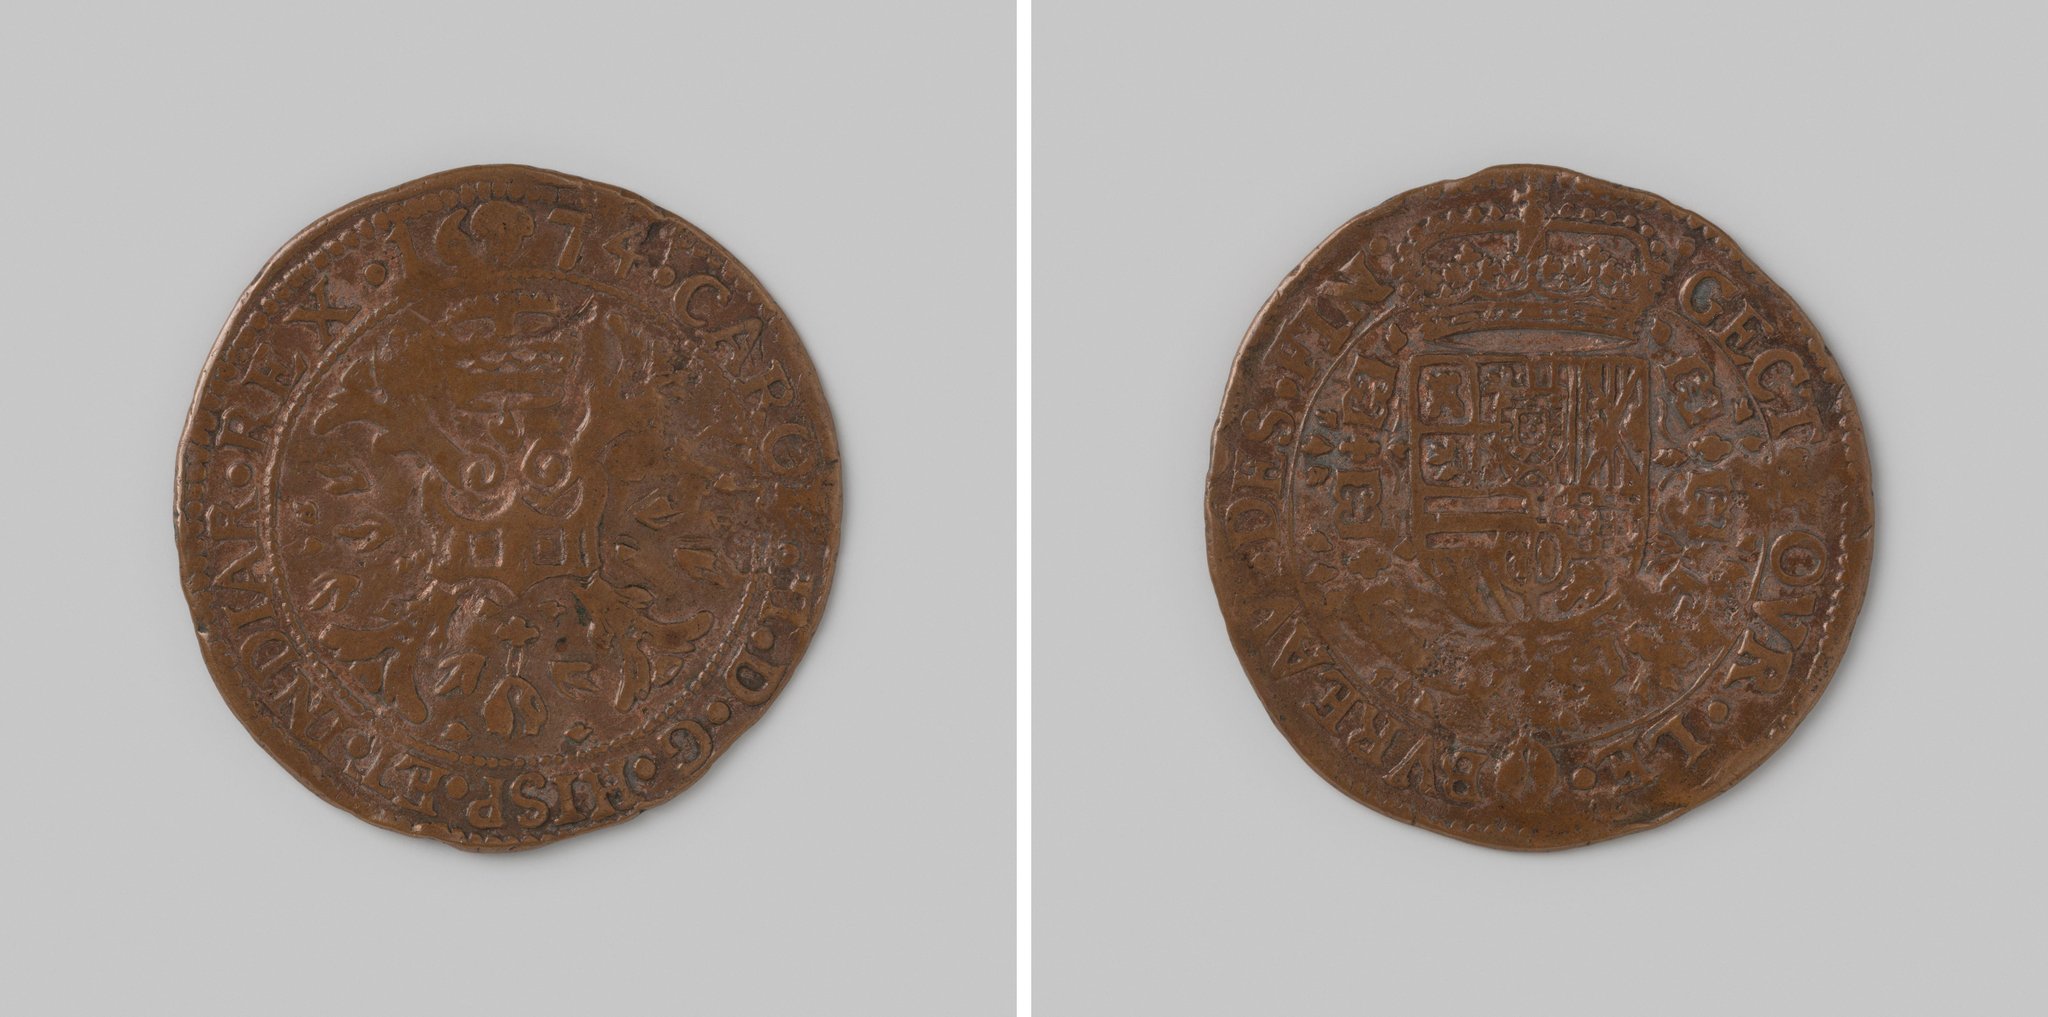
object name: jeton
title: Rekenpenning uit Brussel voor het Bureau van Financien 1674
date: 1674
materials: copper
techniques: striking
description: Koperen penning, op de voorzijde een gekroond vonkend vuurijzer op een andreaskruis, met omschrift, op de keerzijde het gekroonde Spaanse wapenschild omhengen met de keten van het Gulden Vlies, met omschrift.